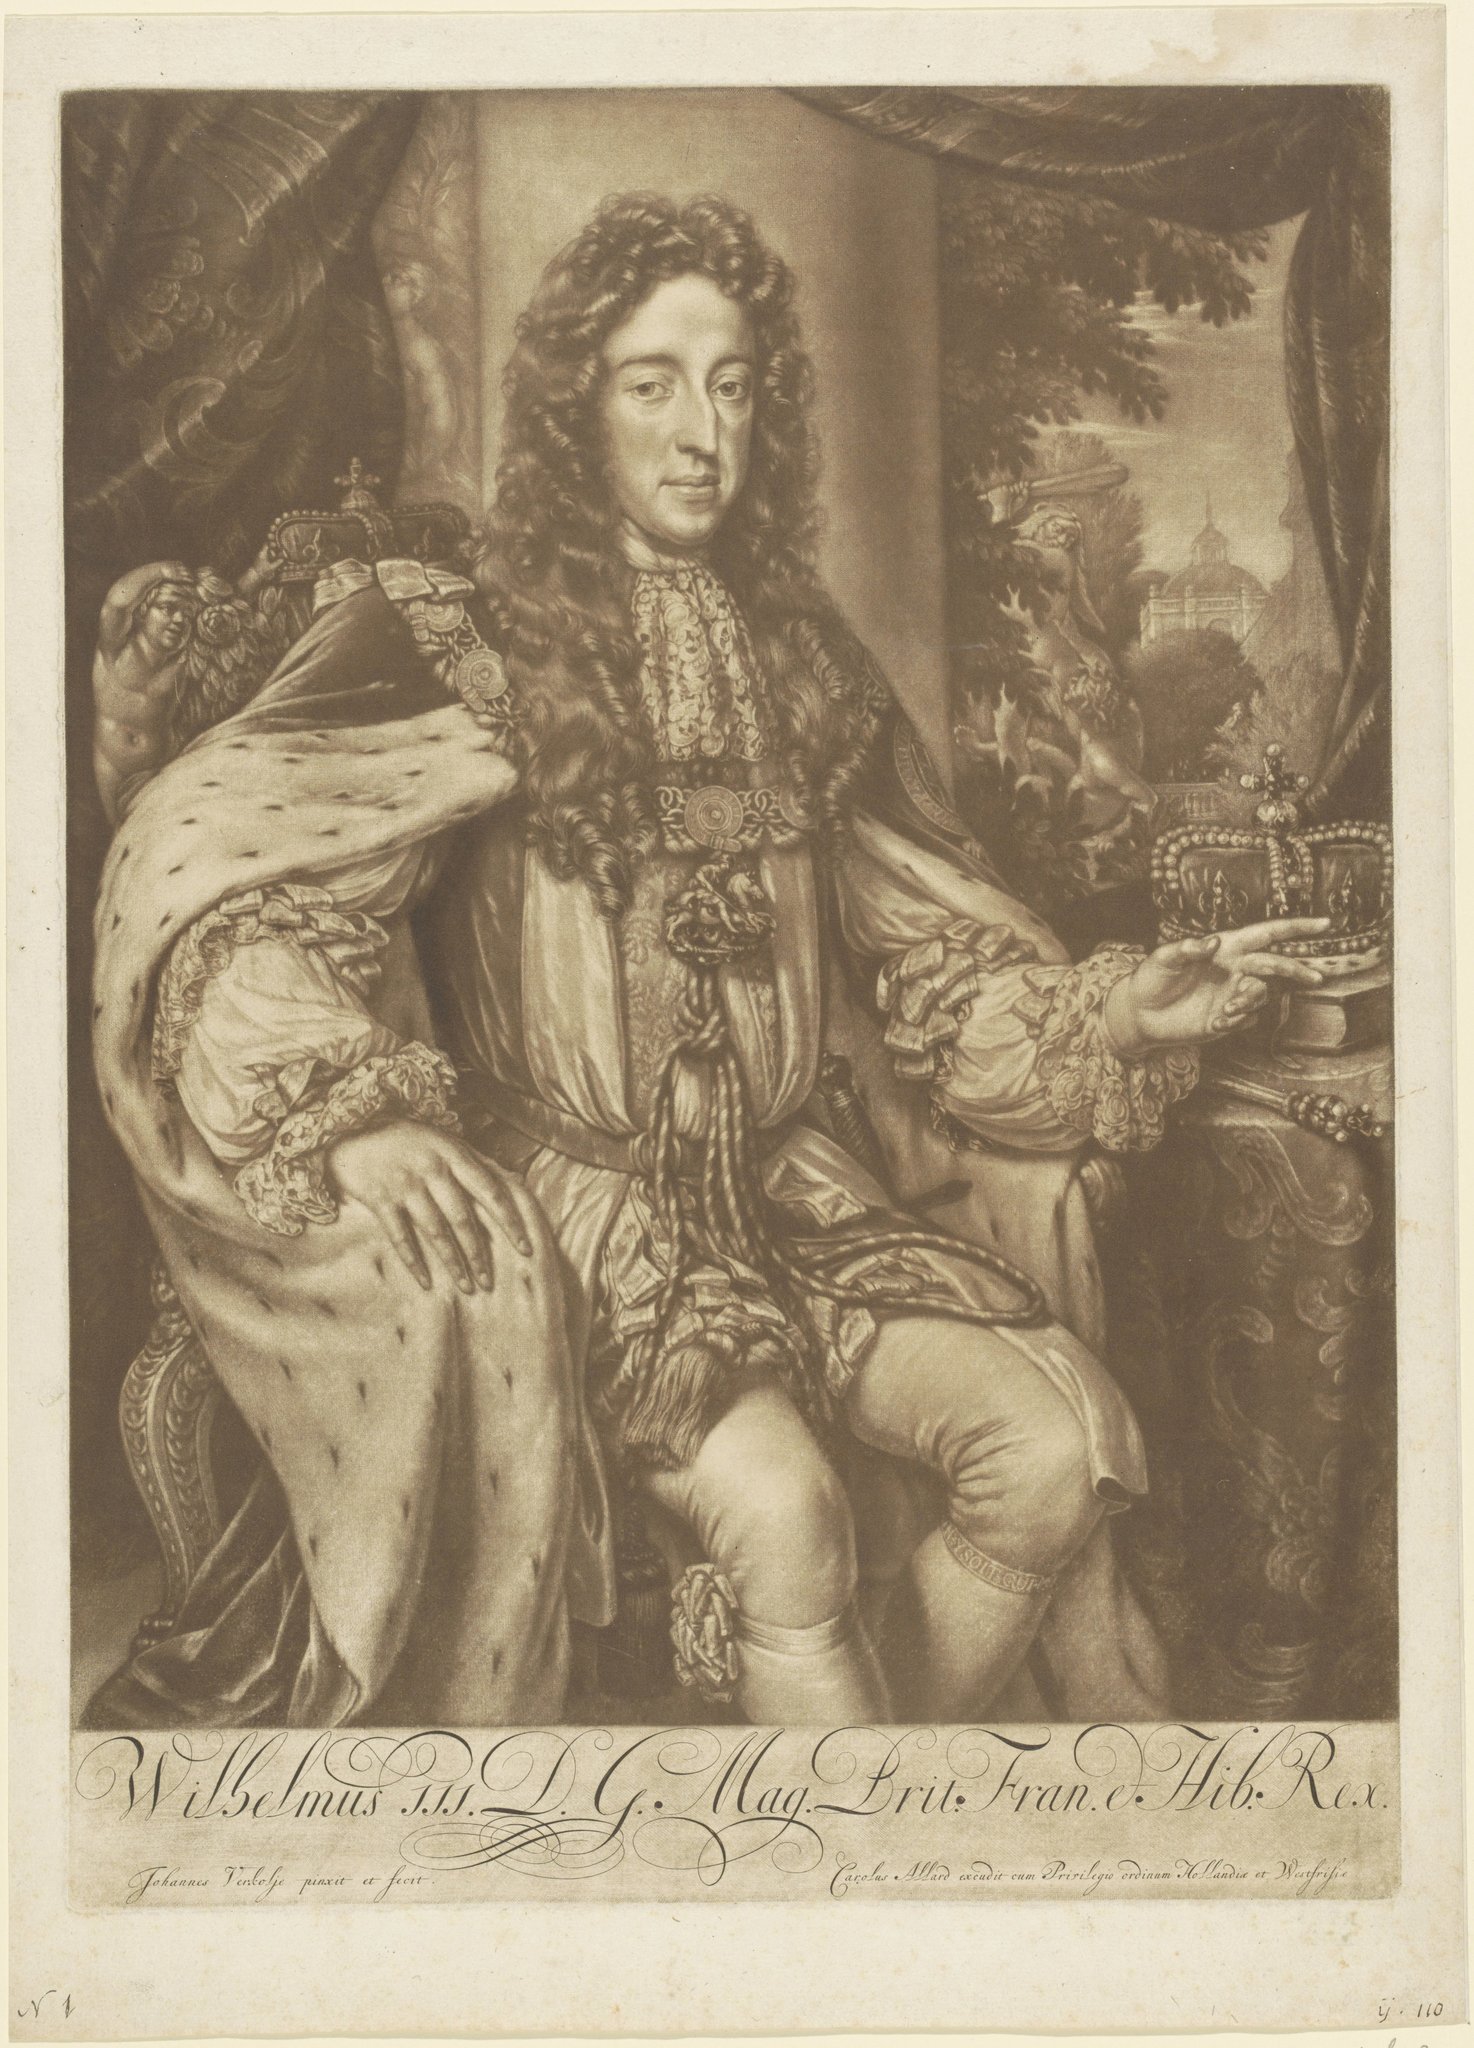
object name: print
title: Portret van Willem III, prins van Oranje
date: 1688-1709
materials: paper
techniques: mezzotint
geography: delft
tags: the hague, william iii (prince of orange and king of england, scotland, and ireland), knighthood order (garter) - insignia of a knighthood order, e.g.: badge, chain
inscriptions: collector's mark: Lugt 2165, collector's mark: Lugt 963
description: De hier vermelde titel verwijst naar de hoogst verkregen titel van de geportretteerde, niet per se naar de titel die de geportretteerde op deze voorstelling draagt.